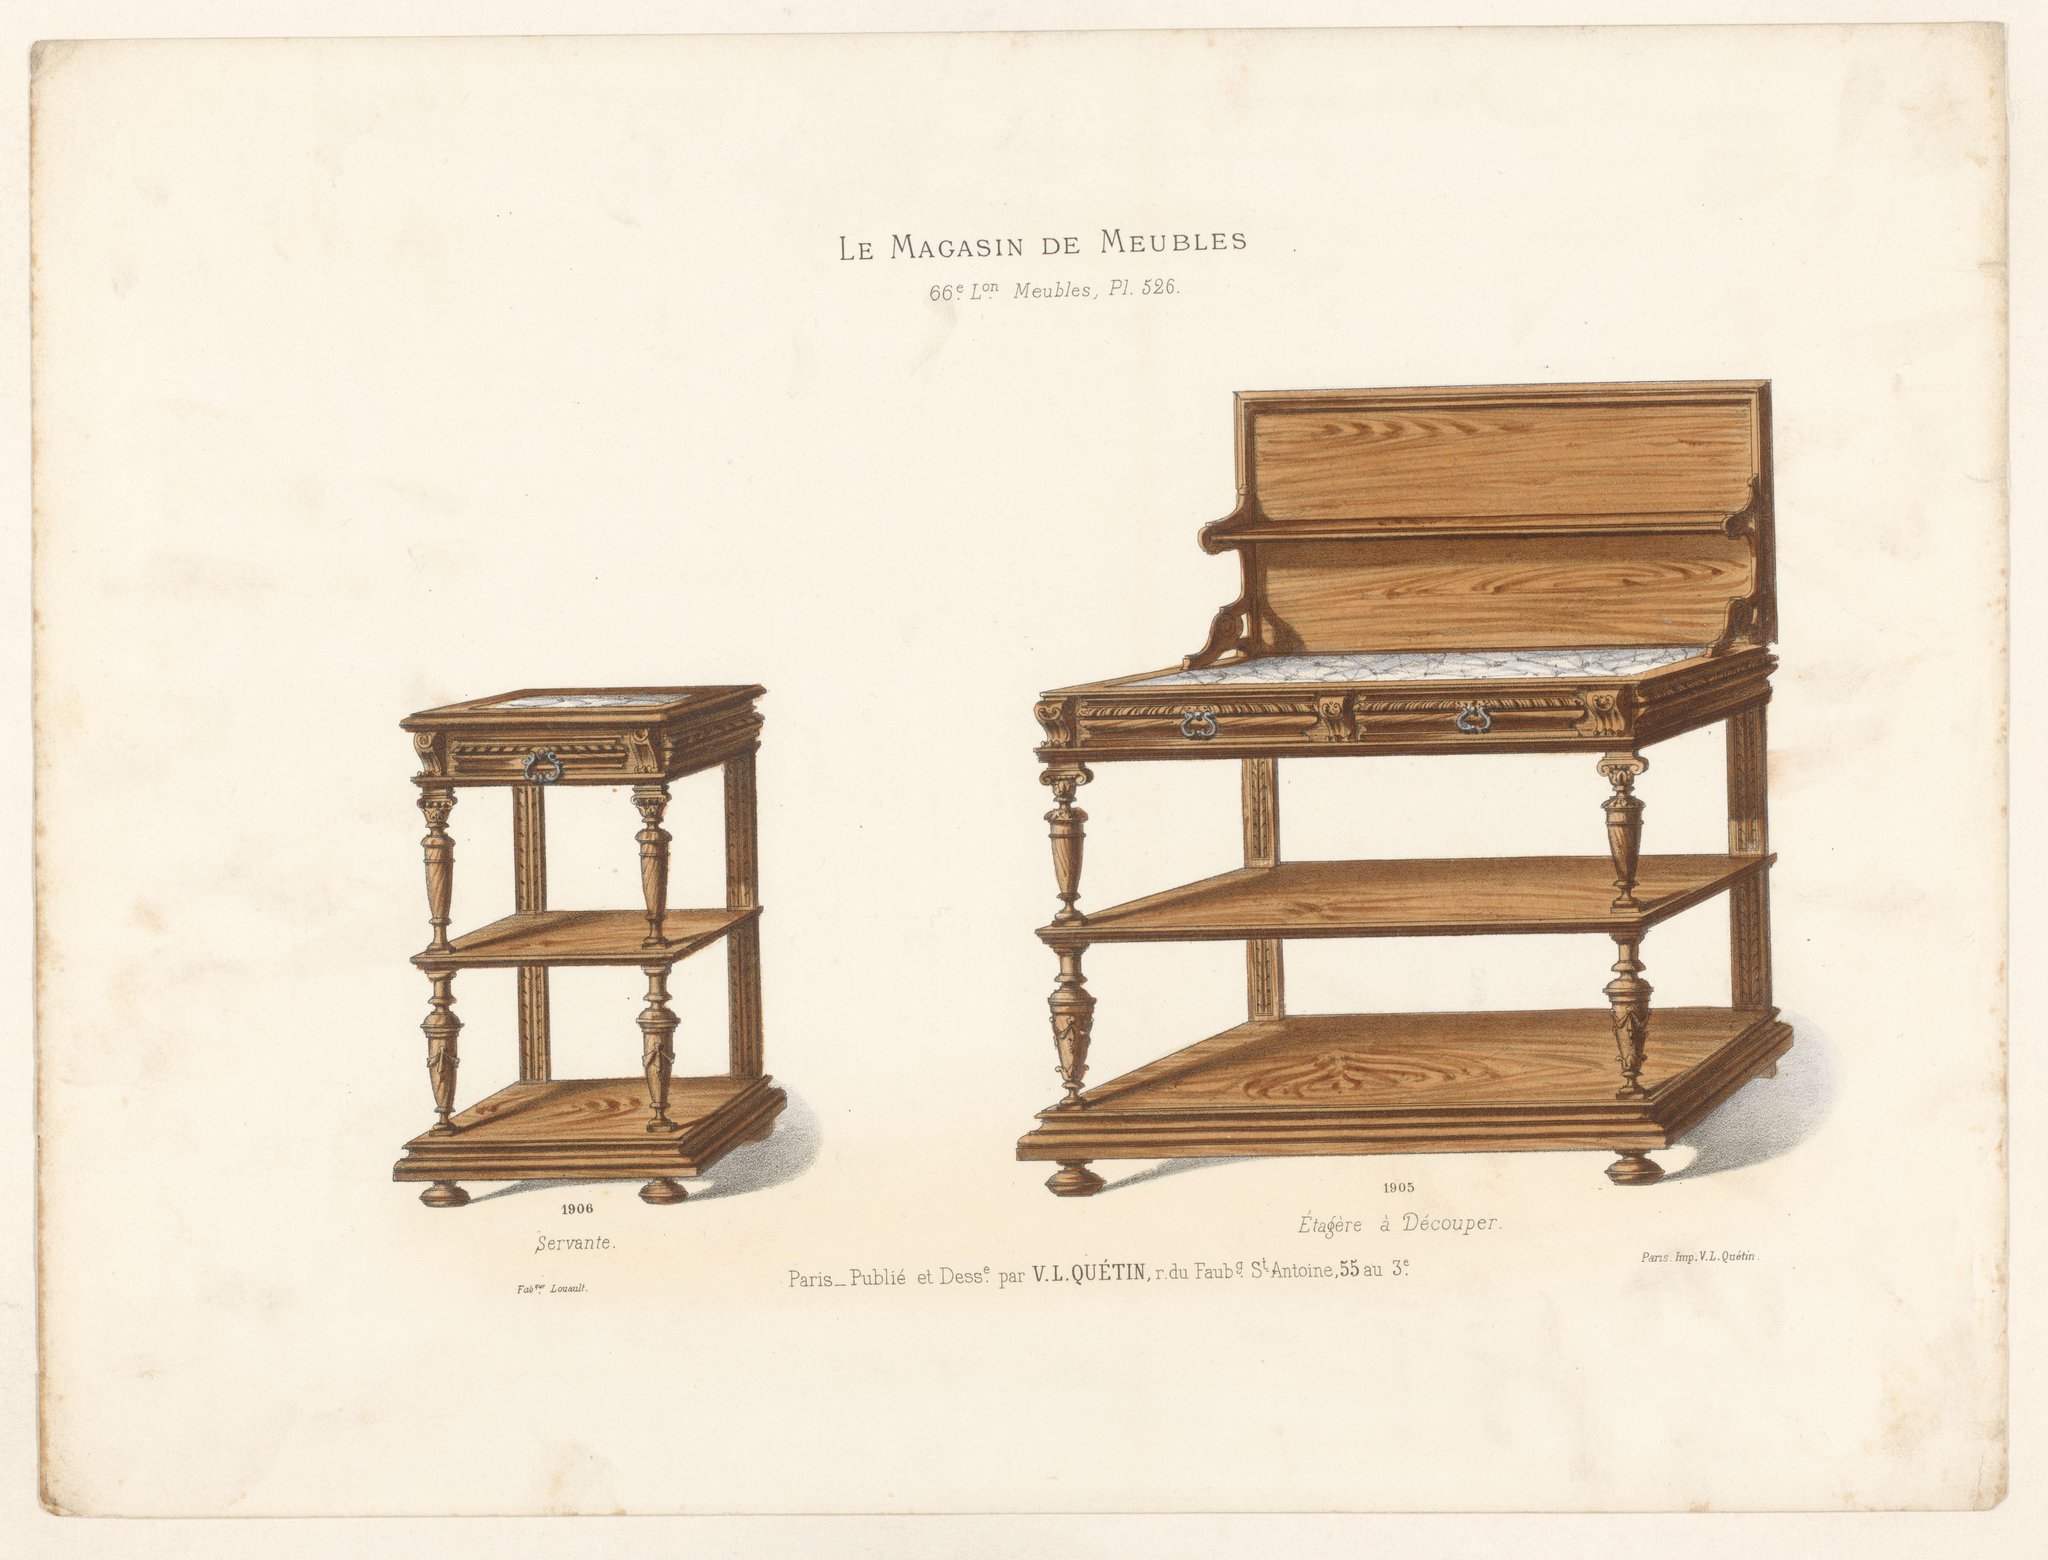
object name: print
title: Le Magasin de Meubles / Meubles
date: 1878-1904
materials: paper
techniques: hand coloring, lithograph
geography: paris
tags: furniture for storage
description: Twee open kasten. Prent uit 66e Livraison.